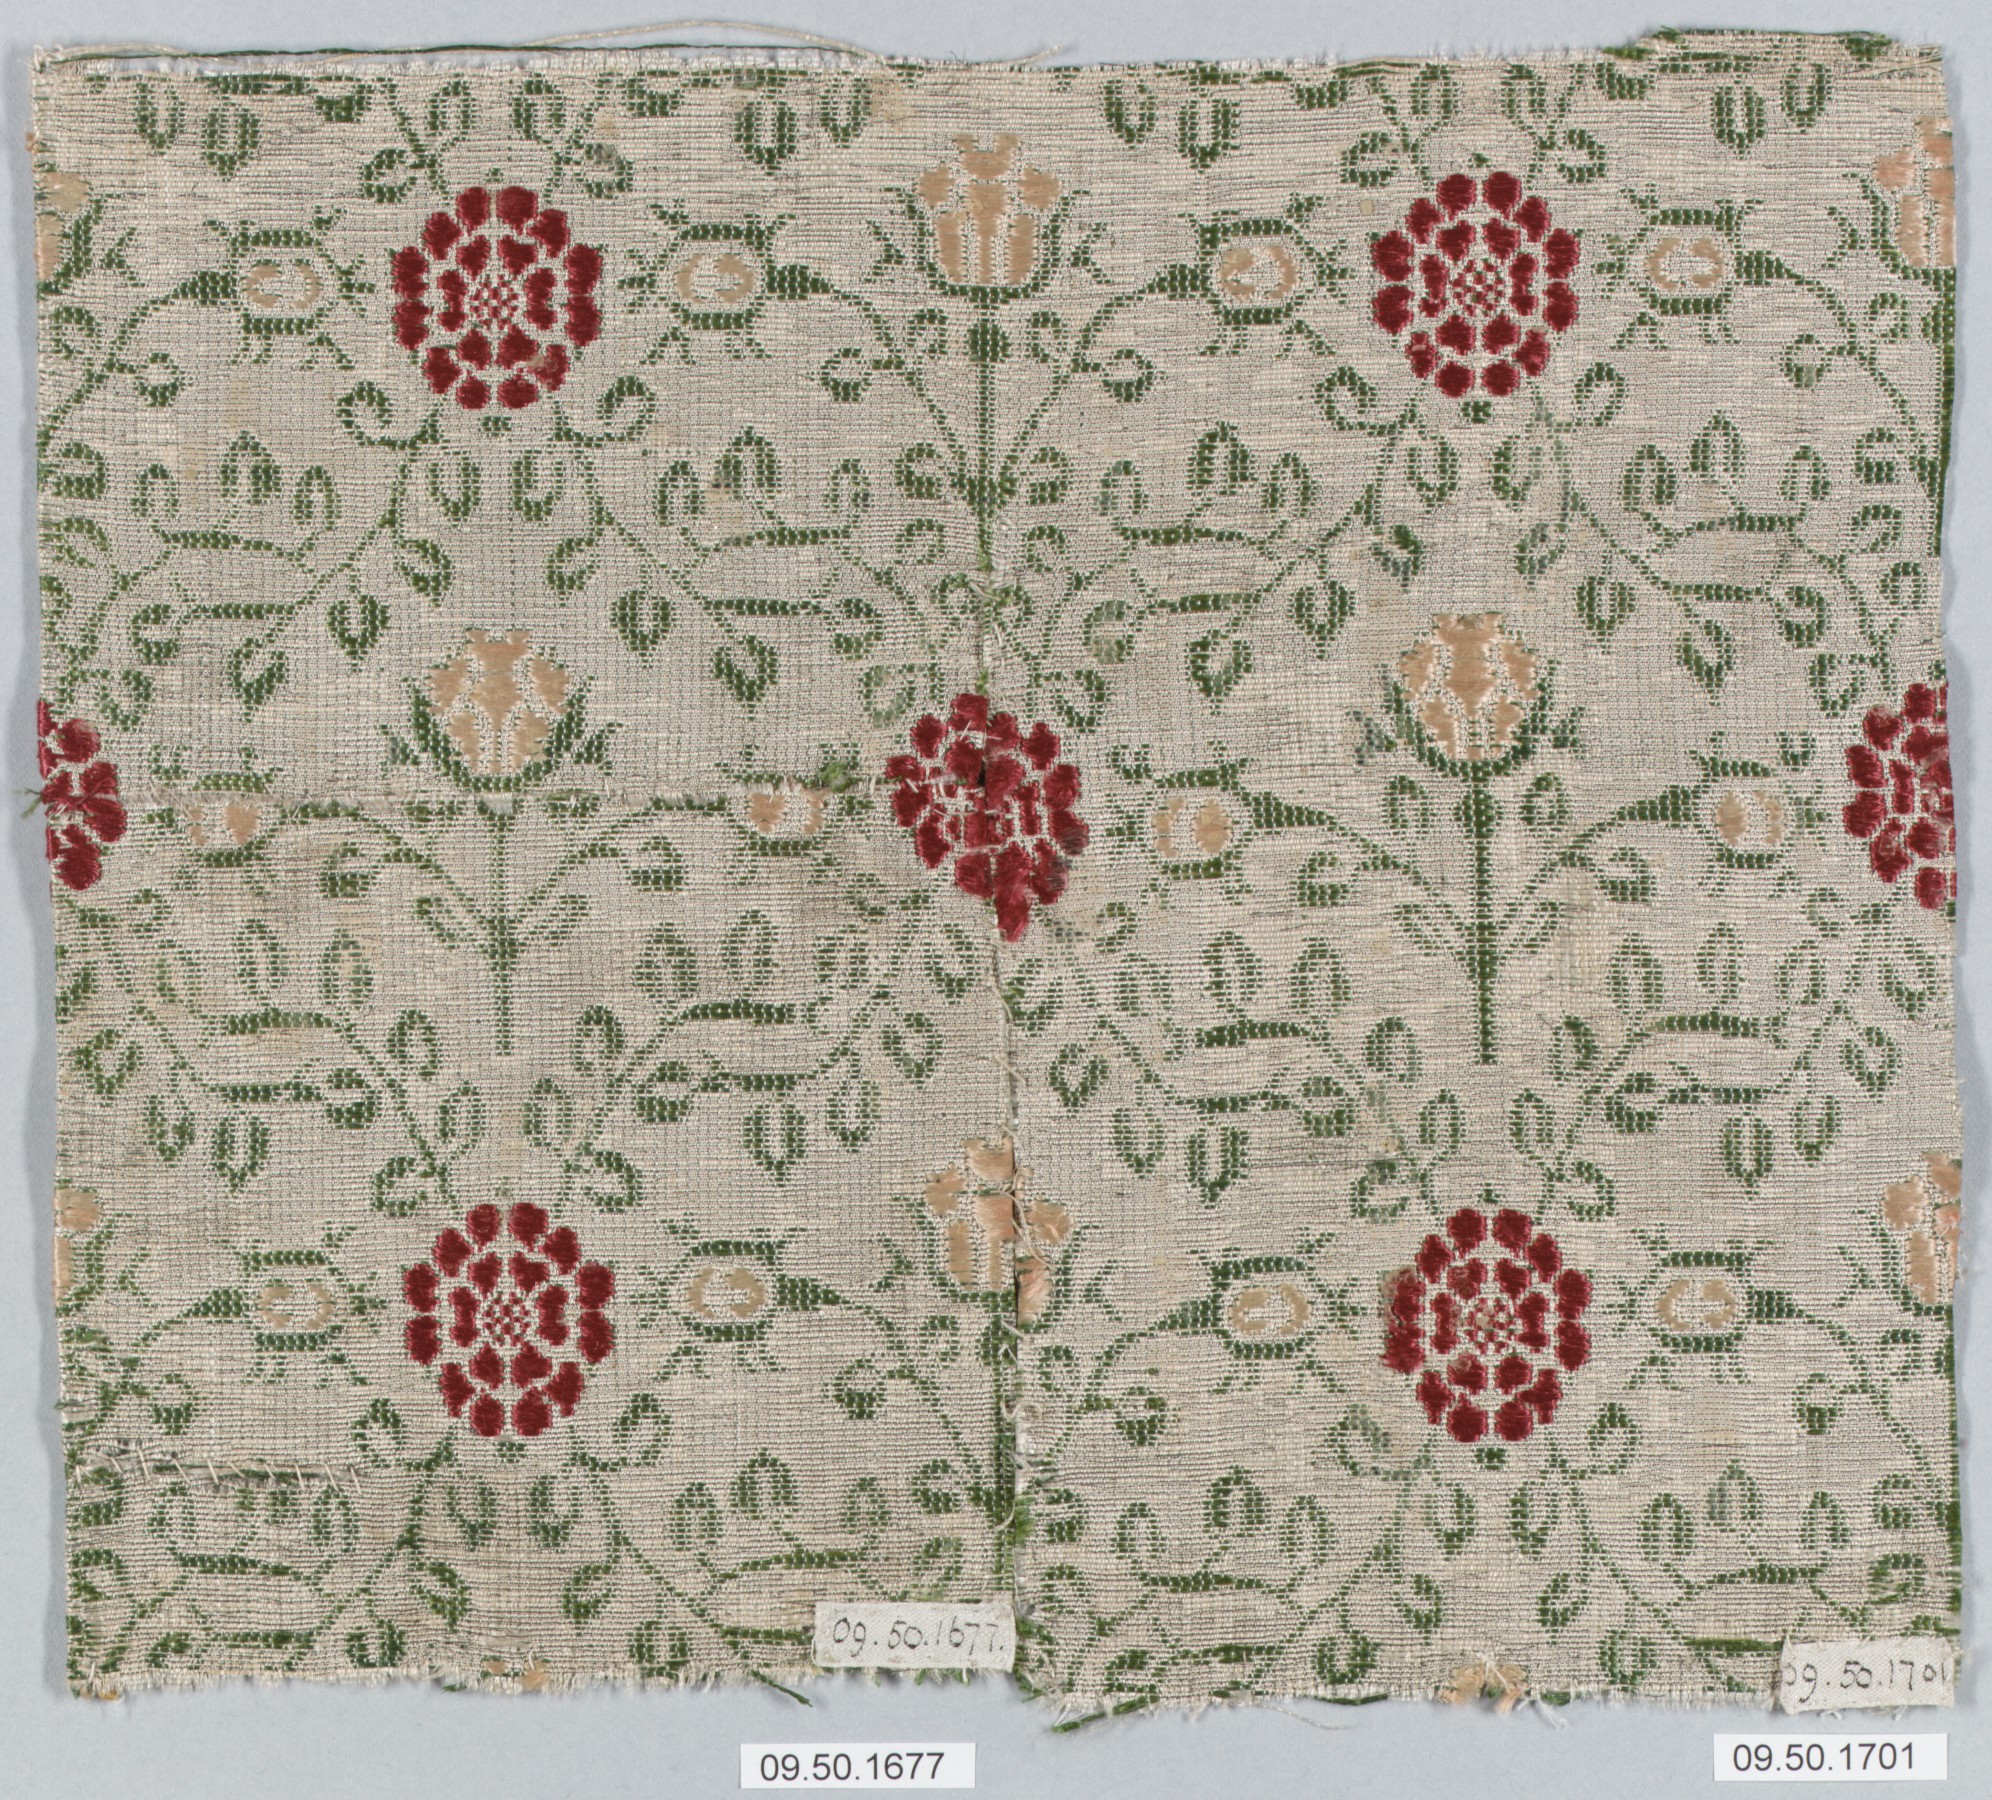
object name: fragment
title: Fragments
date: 1801-1900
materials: metal thread, silk